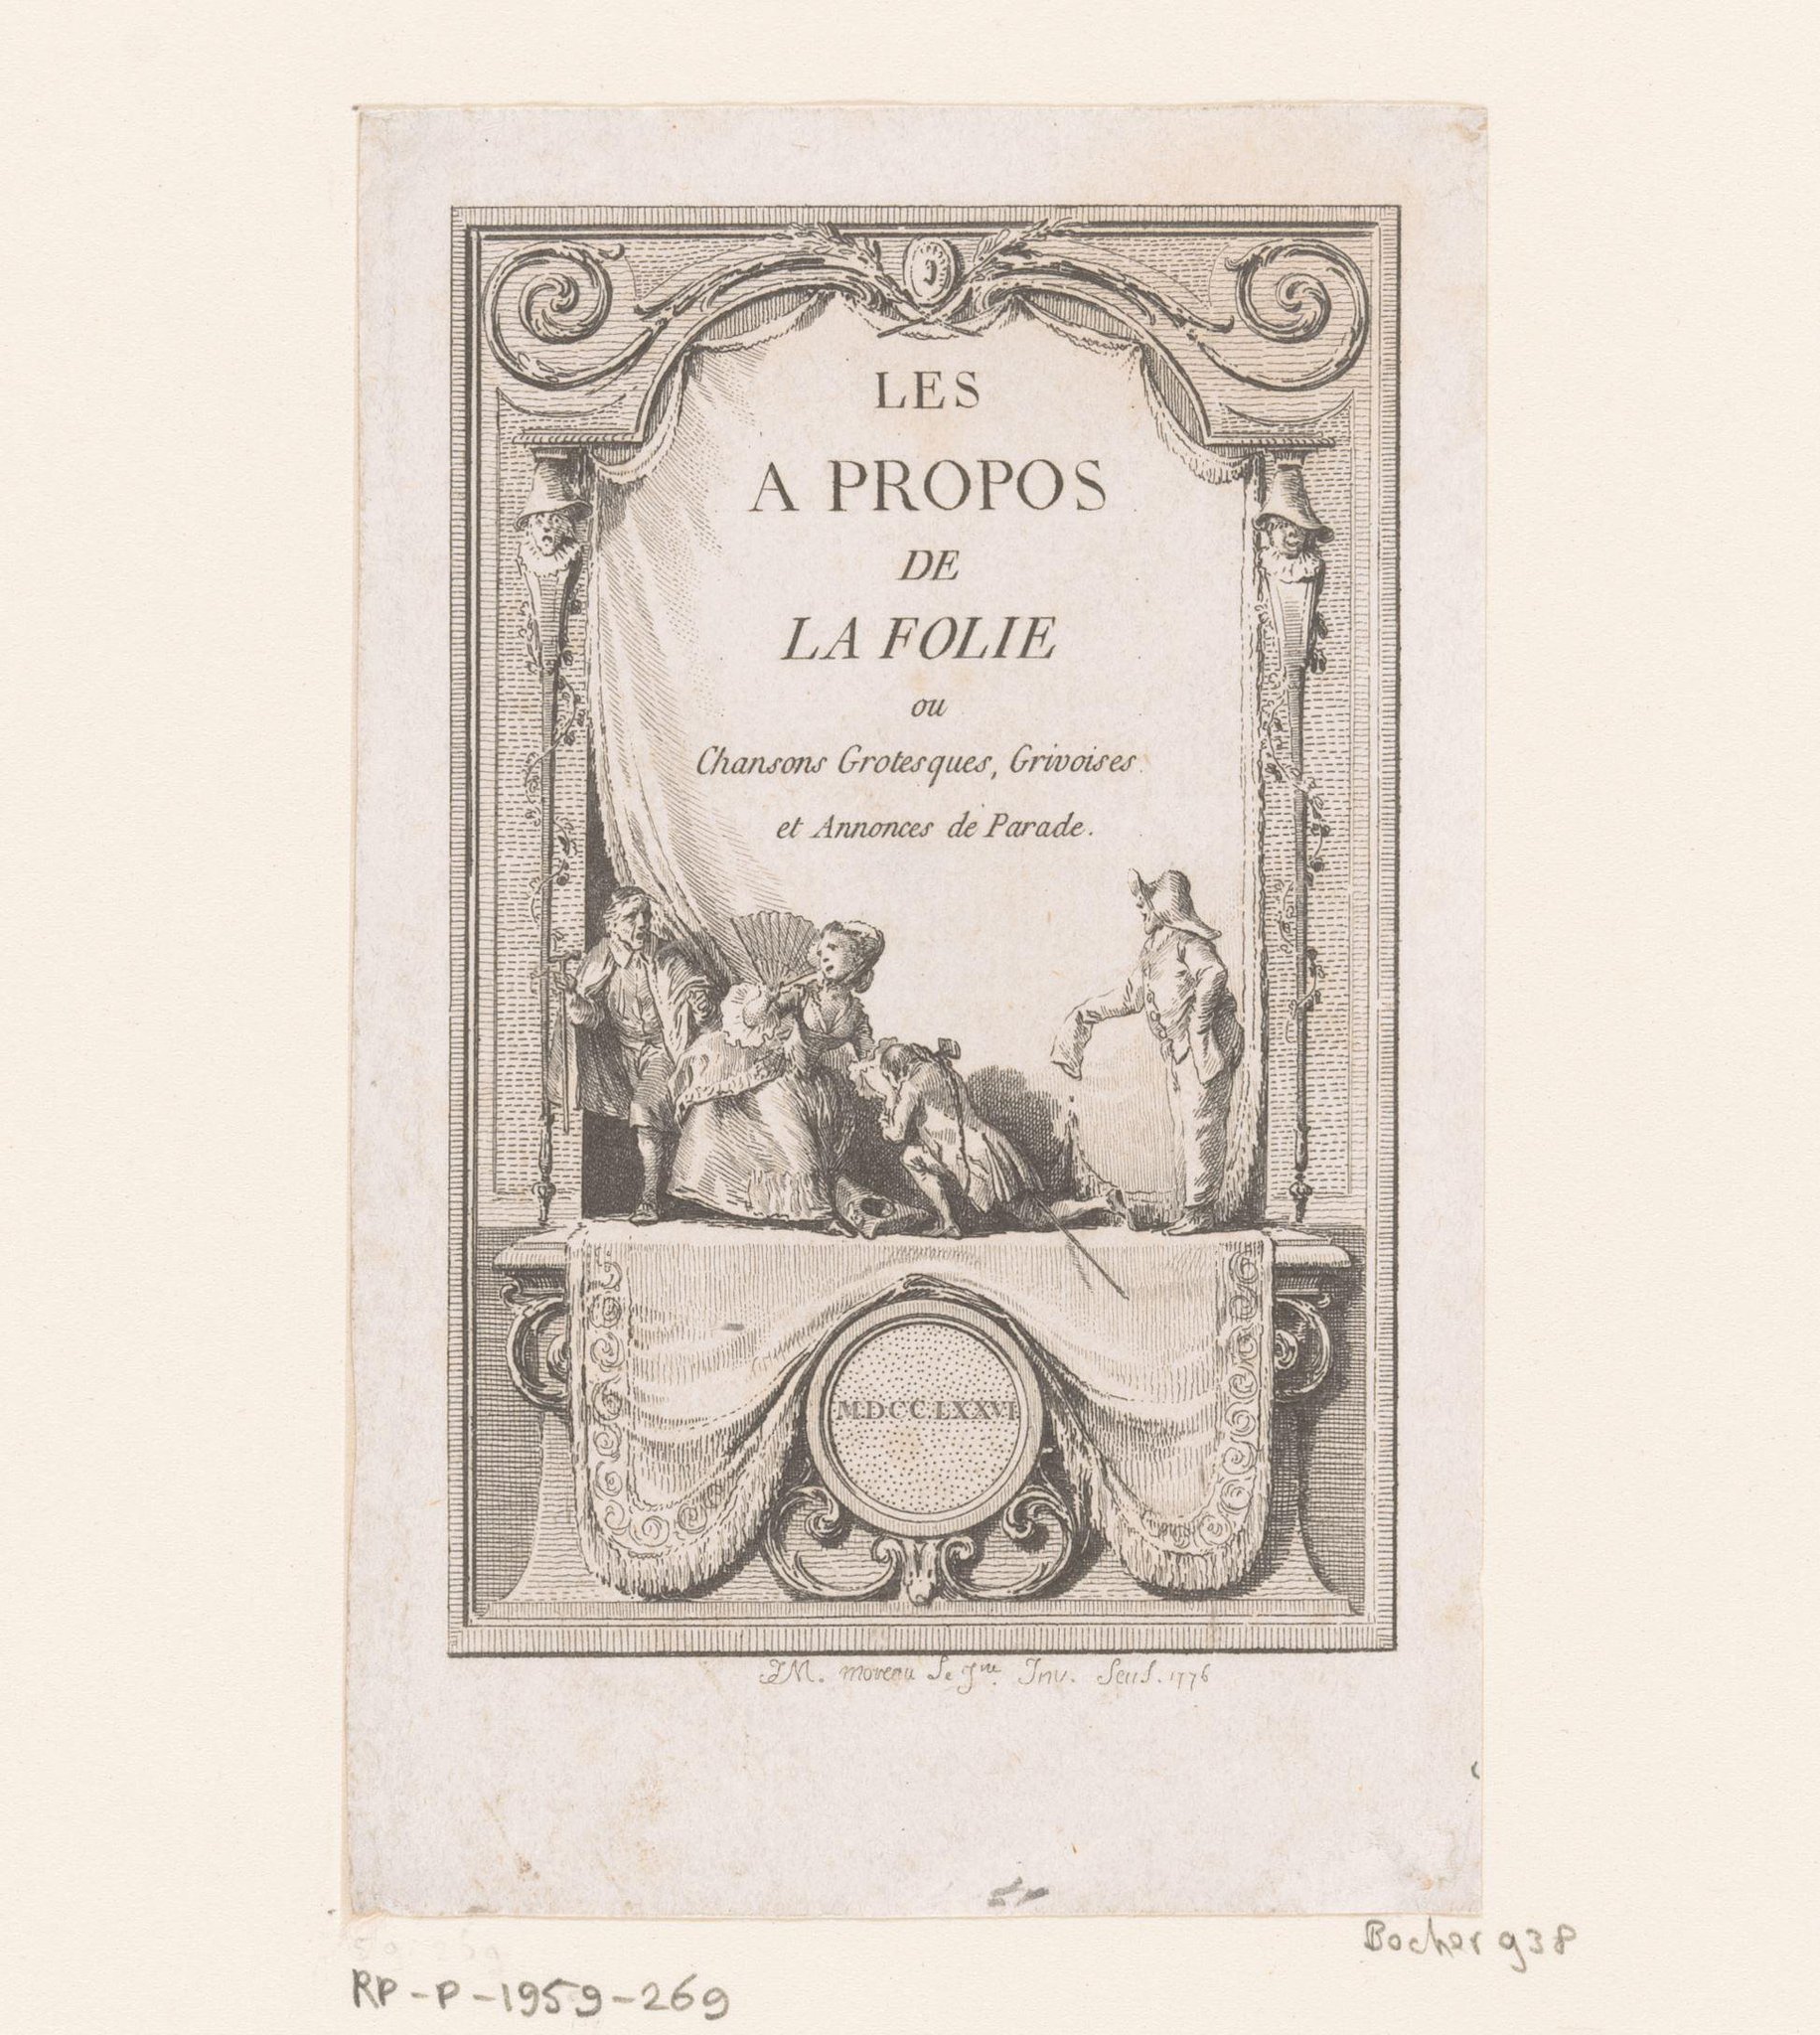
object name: titelblad, titelpagina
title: Titelpagina voor: Pierre Laujon, Les Propos de la Folie (...), 1776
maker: jean michel moreau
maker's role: draughtsman, print maker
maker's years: 1741-1814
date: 1776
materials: paper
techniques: etching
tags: curtain ~ stage, actor (on the stage)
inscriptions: collector's mark: Lugt 2760, collector's mark: Lugt 2228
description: Titelpagina voor: Laujon, Pierre. Les A propos de la folie ou Chansons grotesques, grivoises et annonces de parade. Parijs: s.n., 1776.